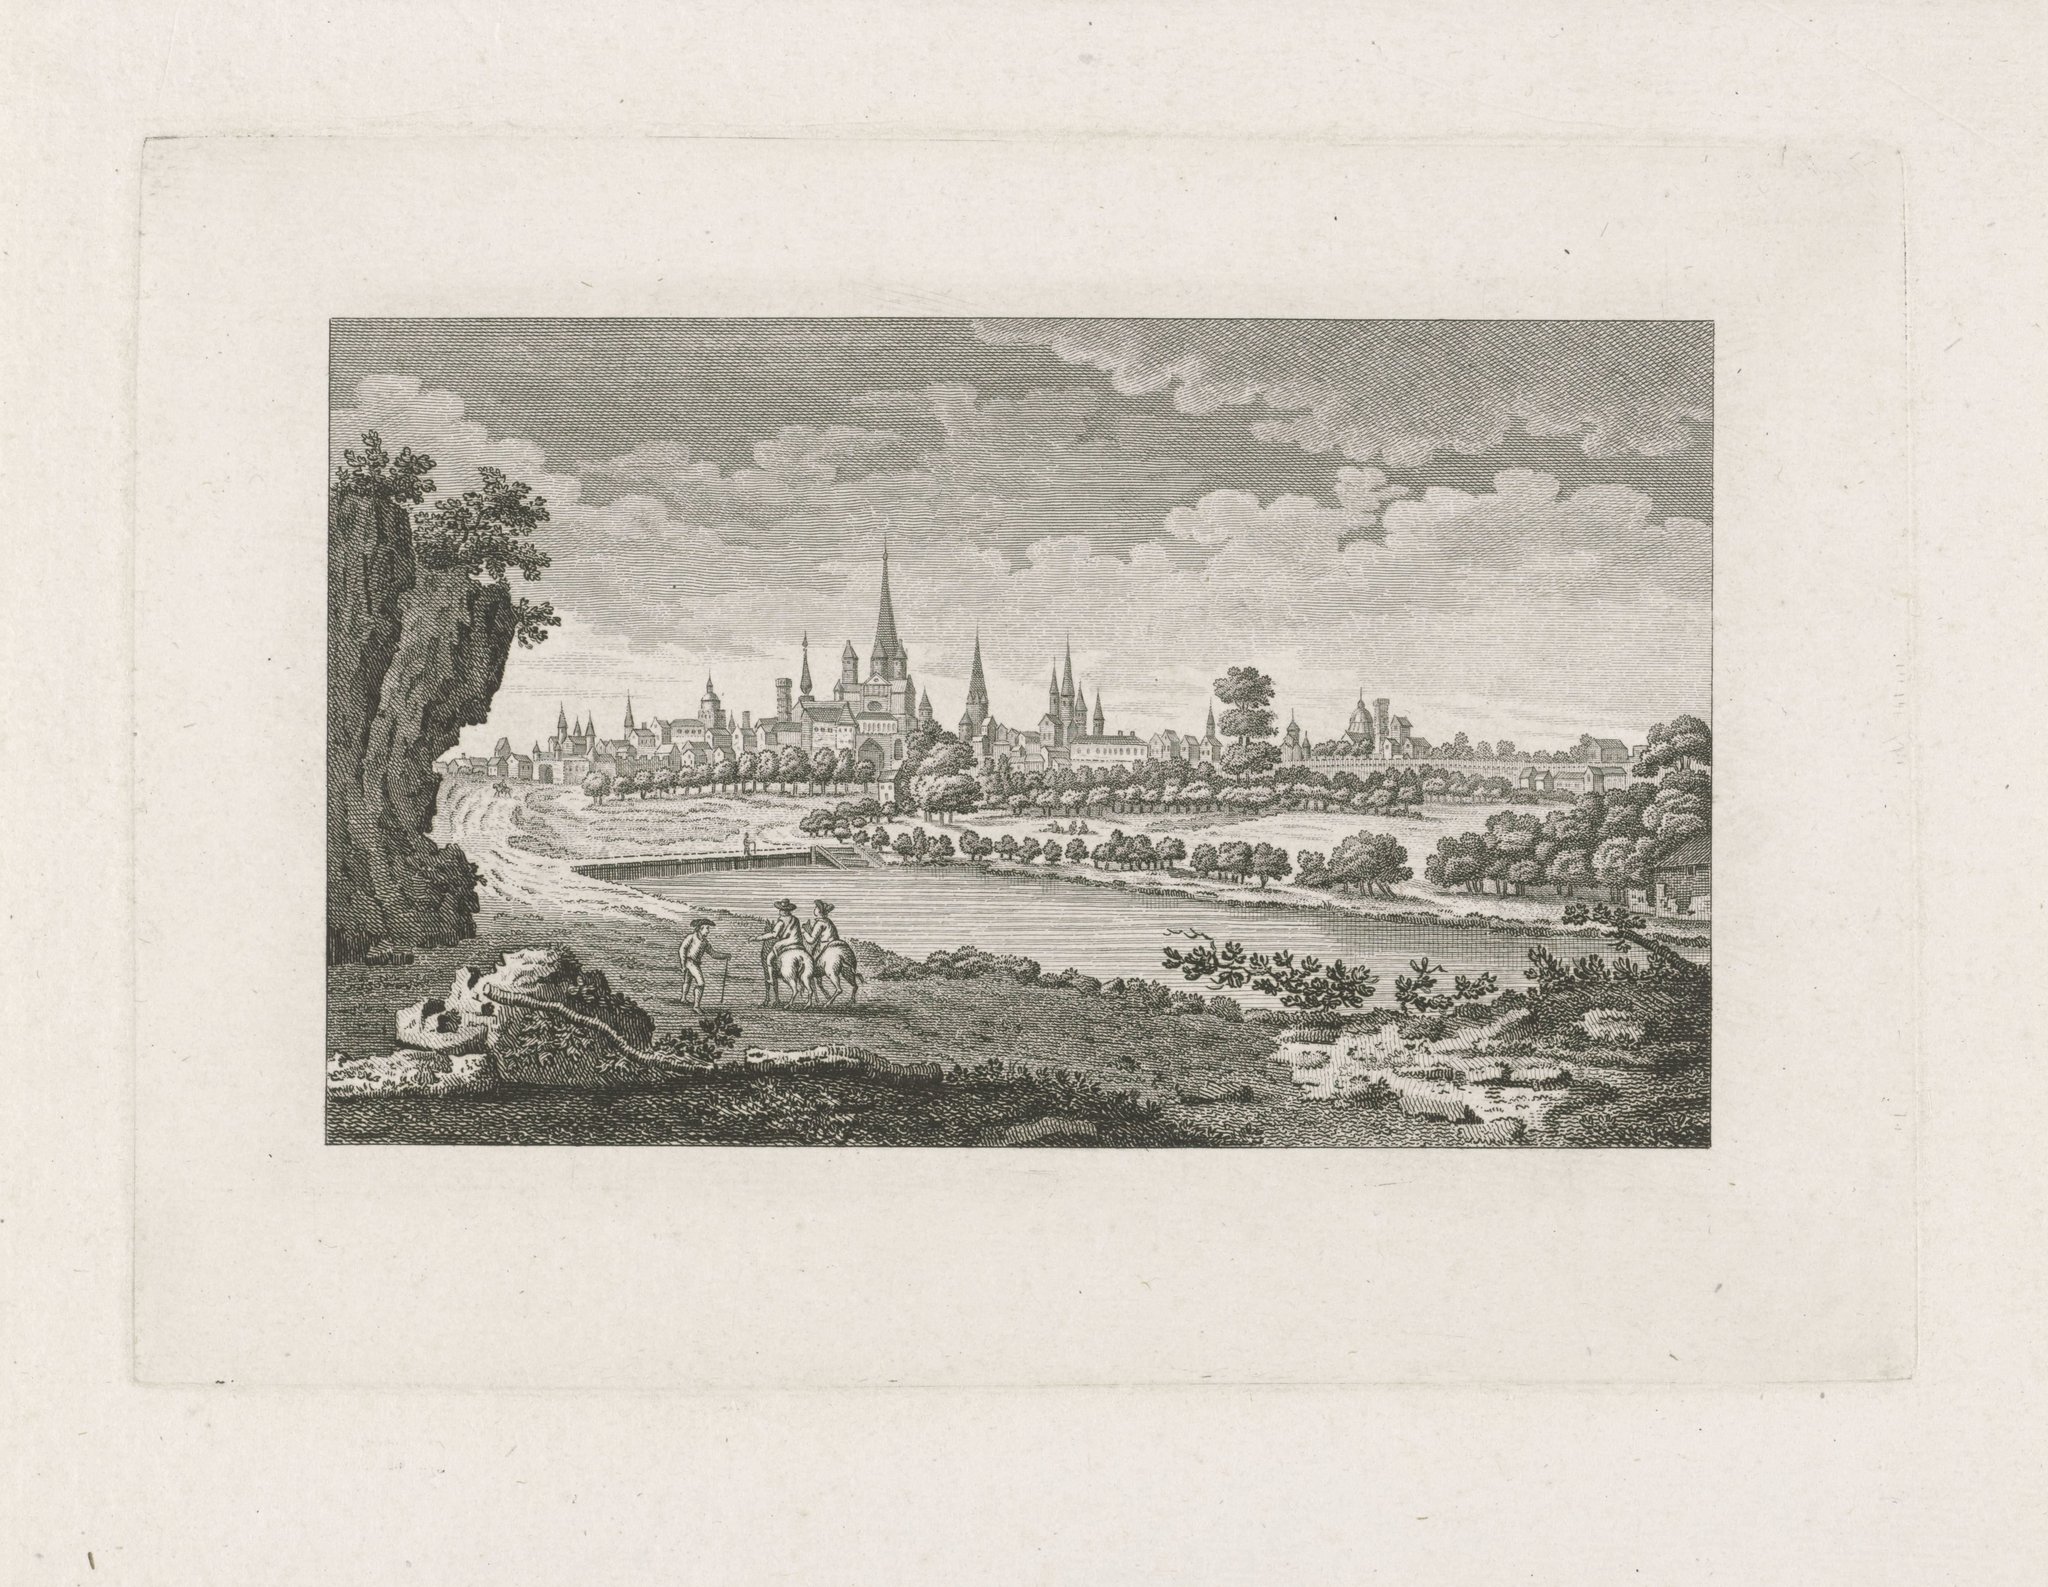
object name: print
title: Gezicht op Dijon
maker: hendrik roosing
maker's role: print maker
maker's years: 1763-1826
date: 1786-1826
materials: paper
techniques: etching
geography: rotterdam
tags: riding a horse, ass, or mule; rider, horseman, church (exterior), 'en route', traveller under way, prospect of city, town panorama, silhouette of city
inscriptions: collector's mark: Lugt 2228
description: Gezicht vanuit het bos op de Franse stad Dijon. Op de voorgrond twee ruiters en een wandelaar.